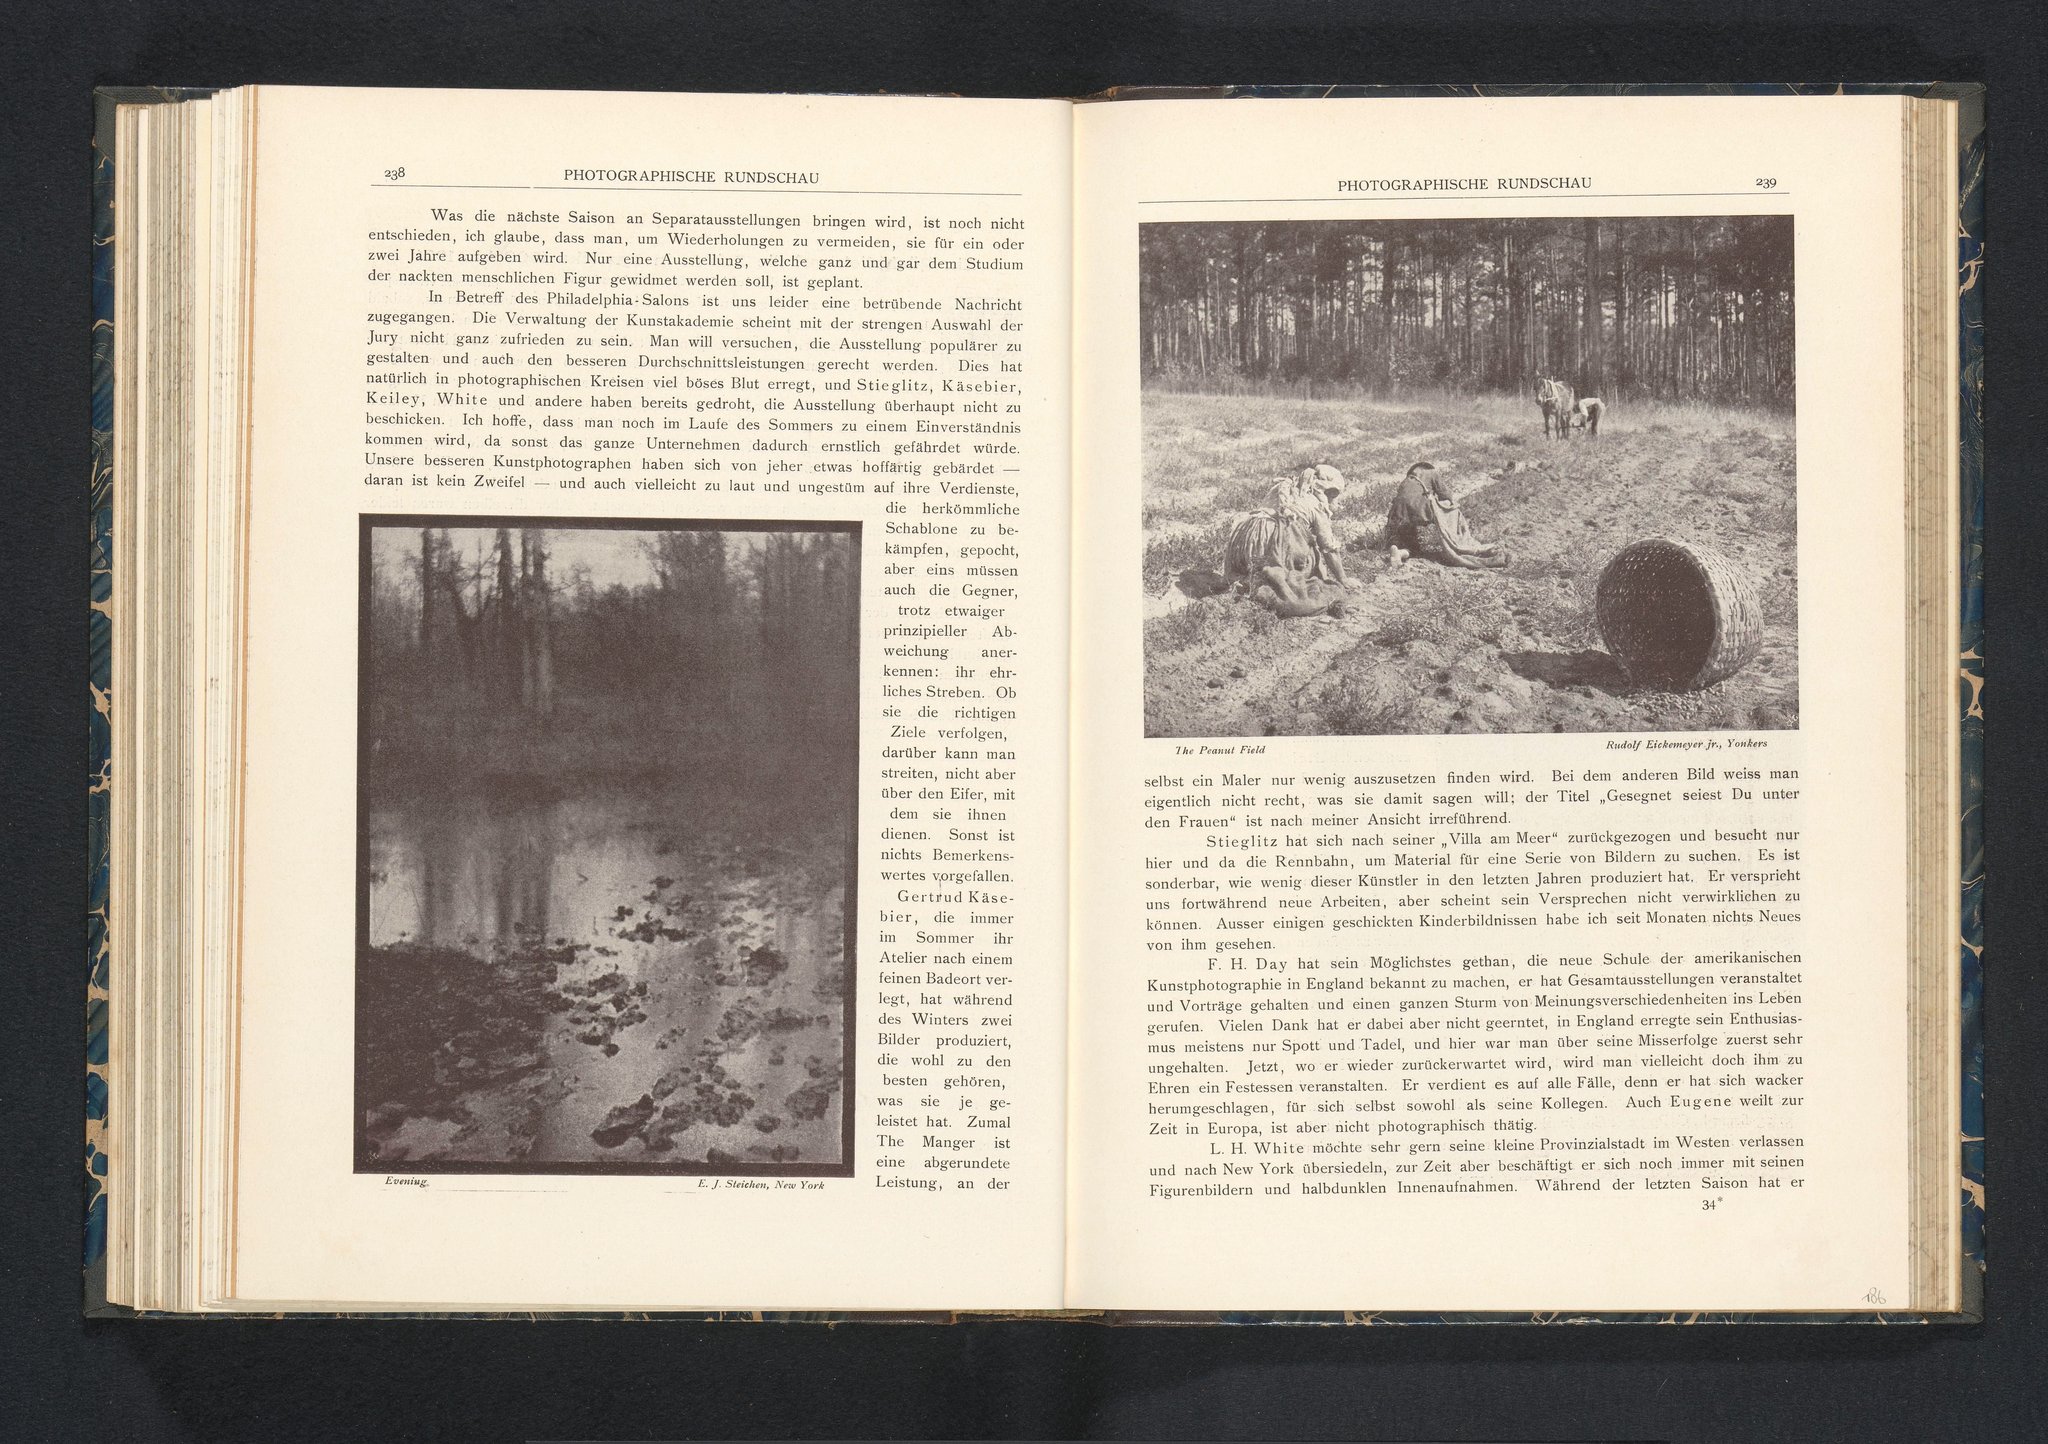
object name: page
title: The Peanut Field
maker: rudolf eickemeyer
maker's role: fotograaf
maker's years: 1862-1932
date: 1896-1901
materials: paper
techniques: autotype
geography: berlin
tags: farmers - aa - female farmer, farmer's wife, cultivation ~ agriculture